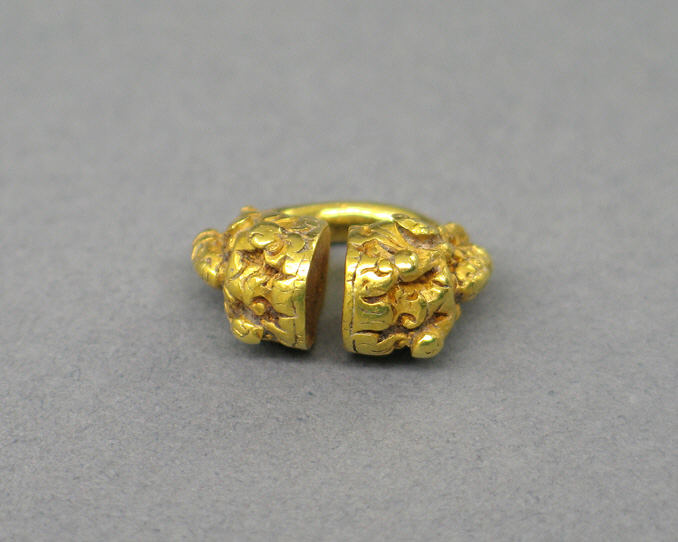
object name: ear clip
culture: indonesian, javanese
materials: gold